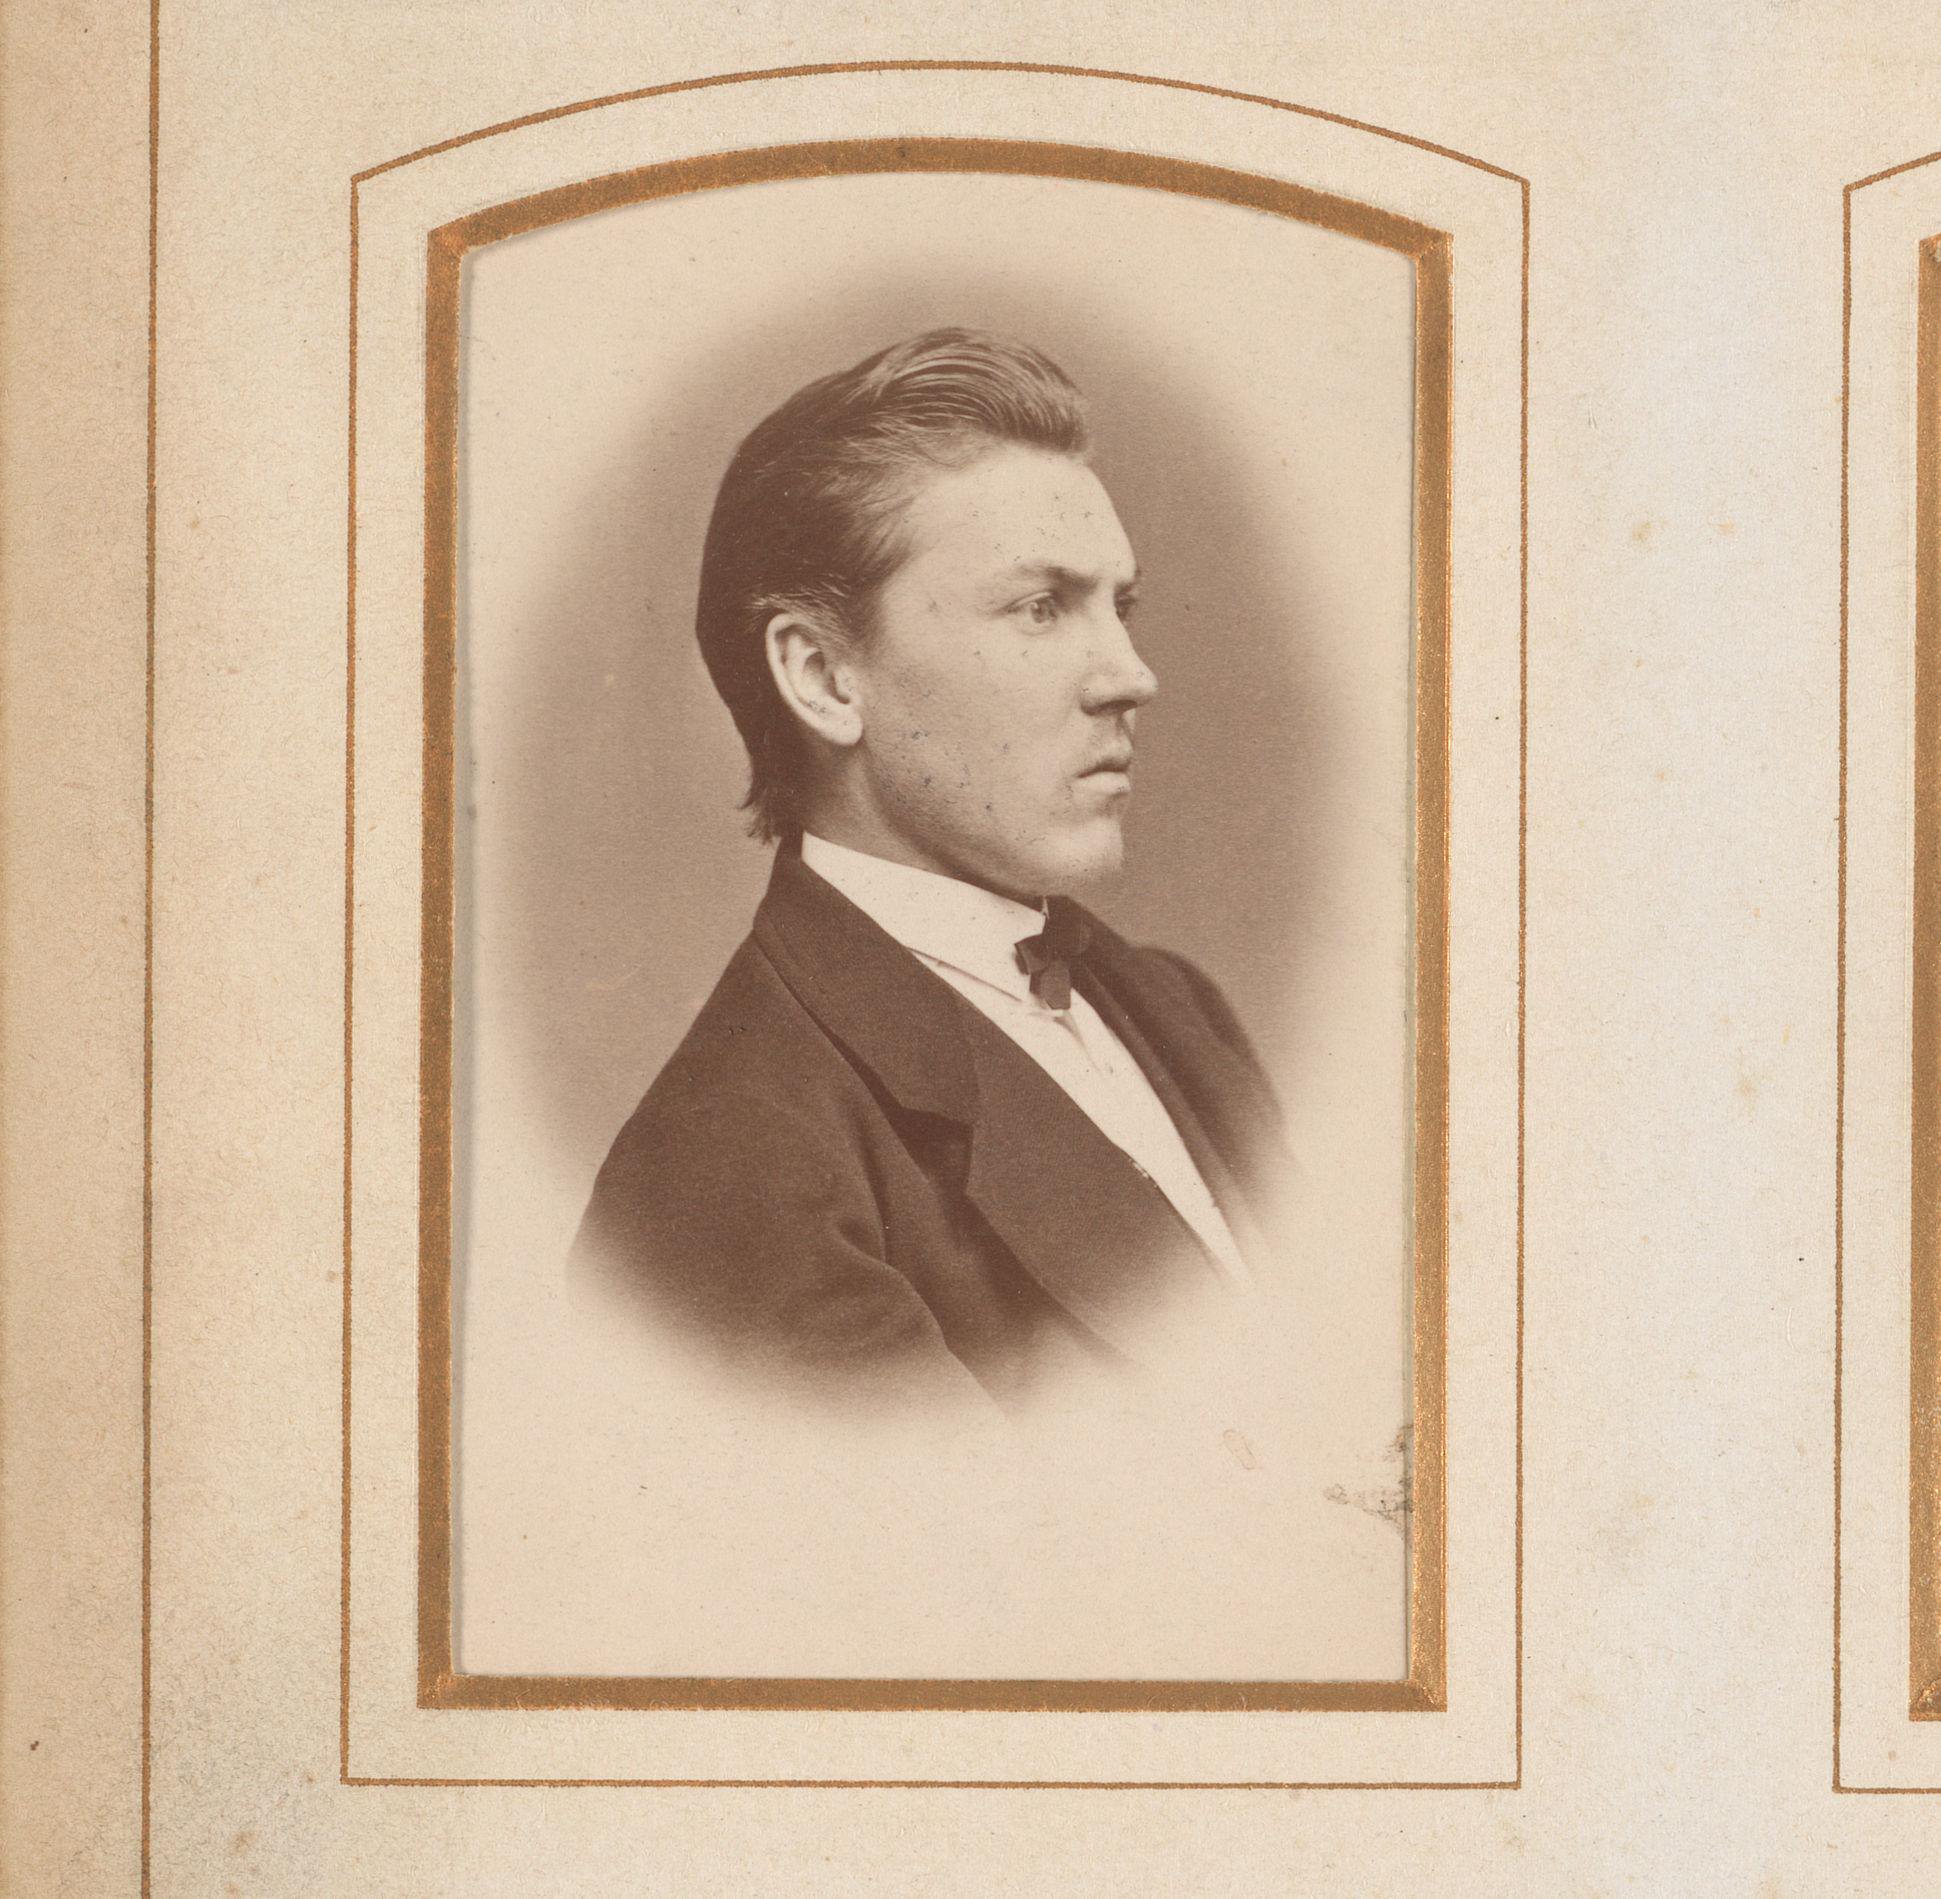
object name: carte de visite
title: Portret van een man, en profil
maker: anders anderzon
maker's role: fotograaf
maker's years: 1834-1916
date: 1860-1900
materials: cardboard, photographic support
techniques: albumen print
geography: strängnäs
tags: historical persons, adult man (+ right side visible; right - (r. hand, r. foot, etc.))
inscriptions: inscription: ‘A. ANDERZONs./ Fotografi Atelier/ STRENGNÅS.’